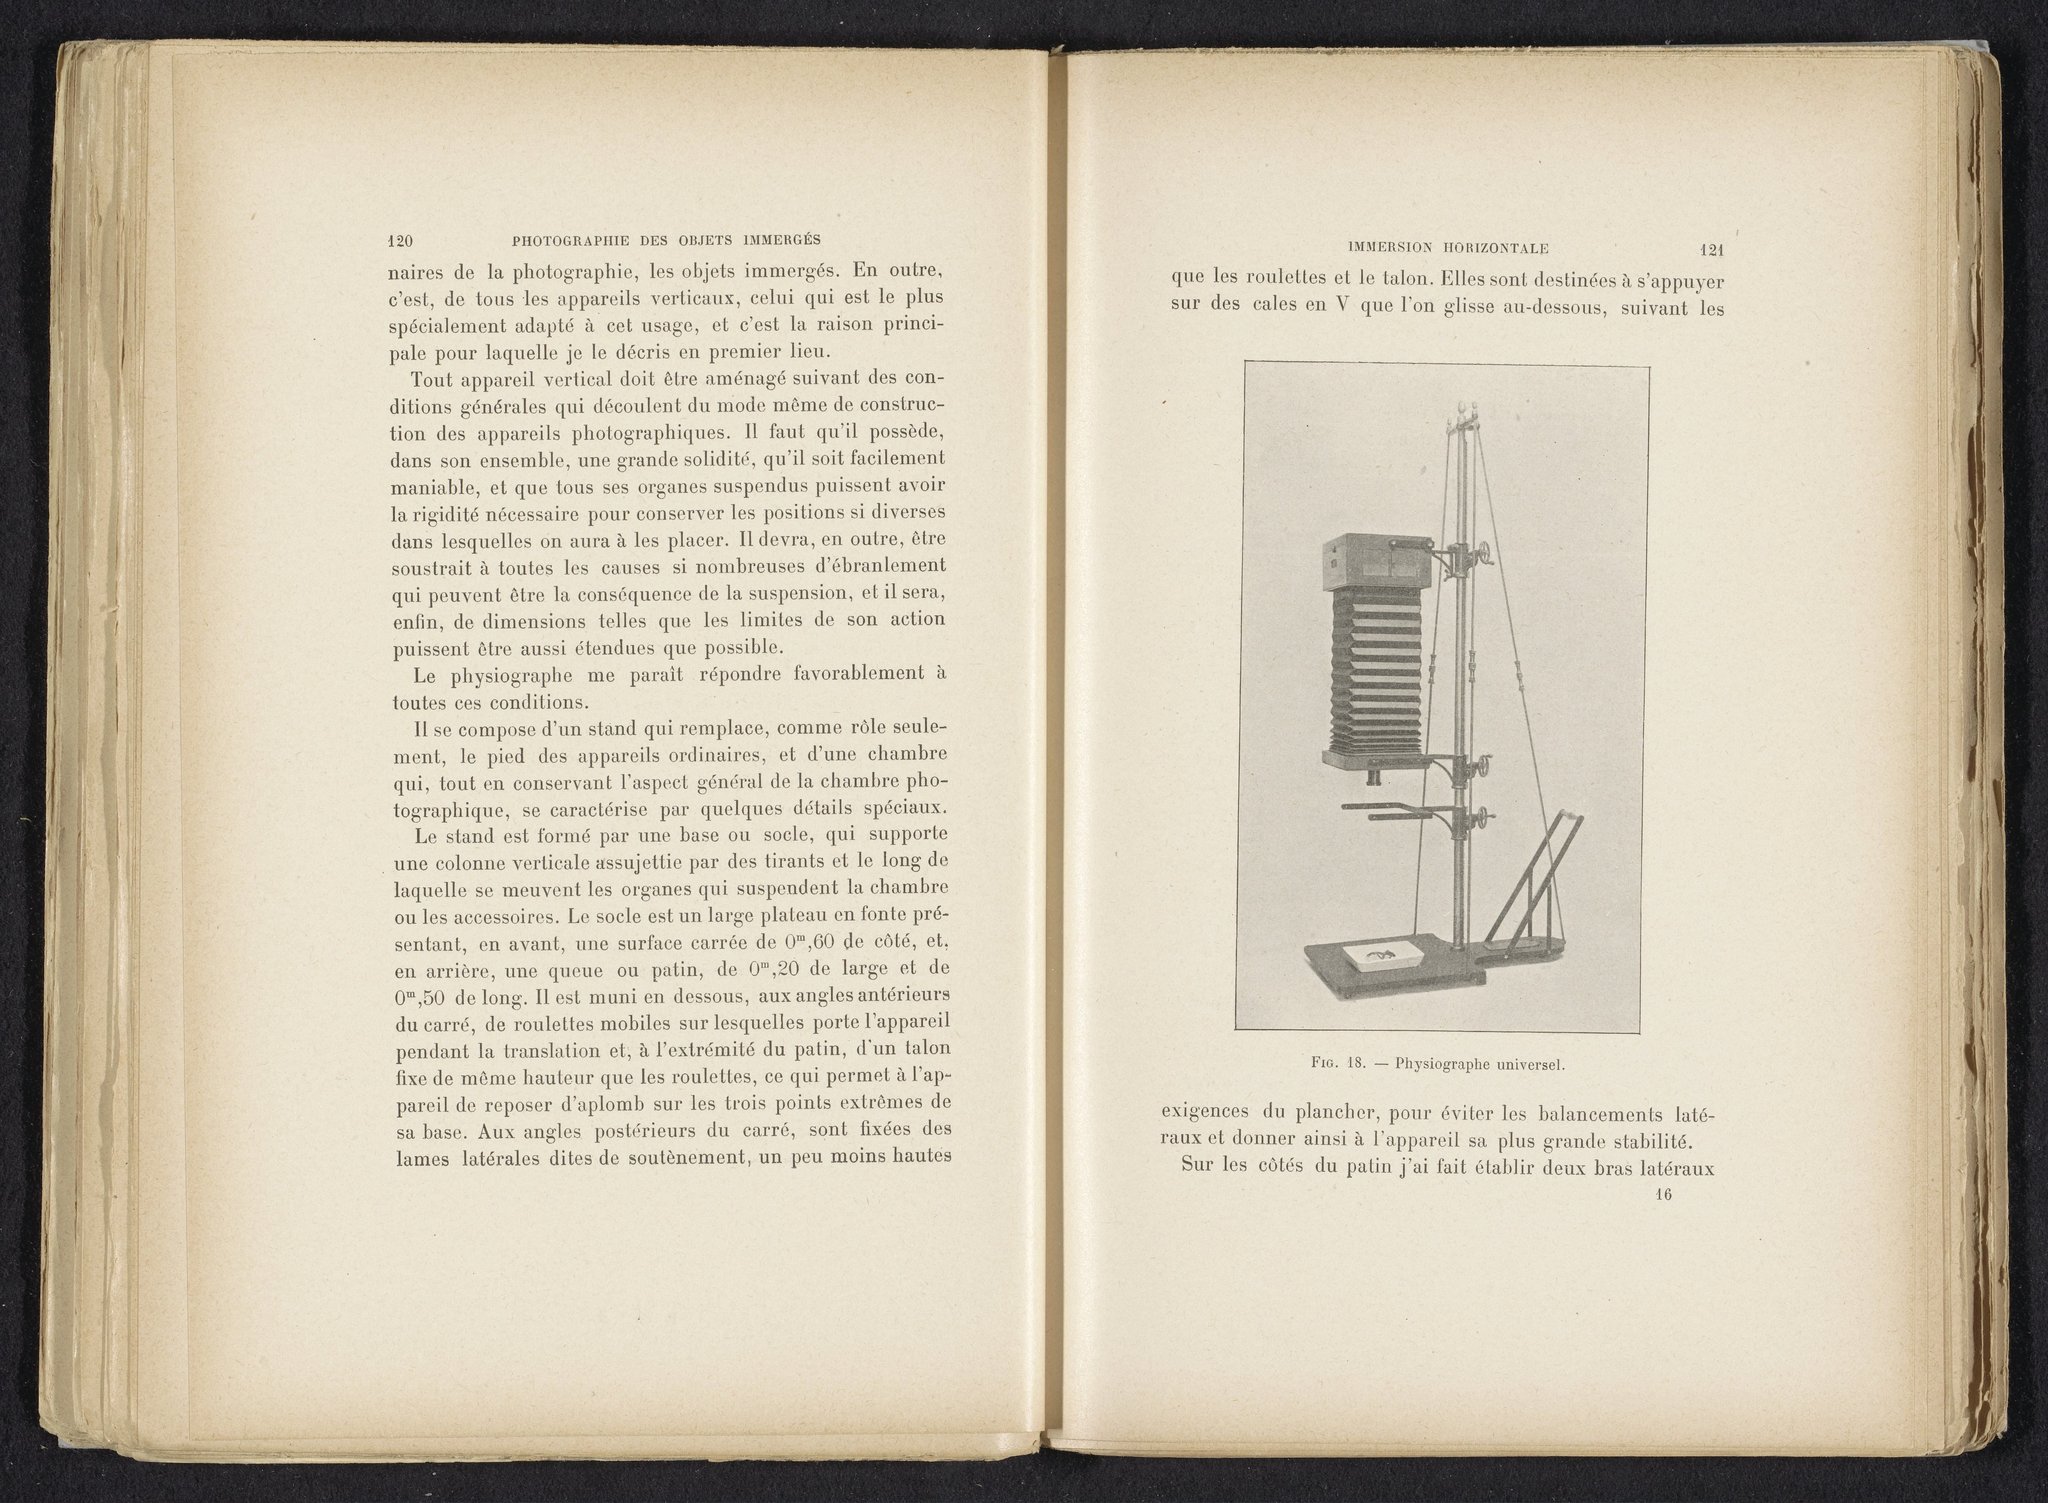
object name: page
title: Universele physiograaf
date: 1891-1901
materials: paper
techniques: autotype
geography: paris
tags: drawing-instruments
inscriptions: number: ‘Fig. 18.’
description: Prent in album 'La photographie des objets immergés', 1901.